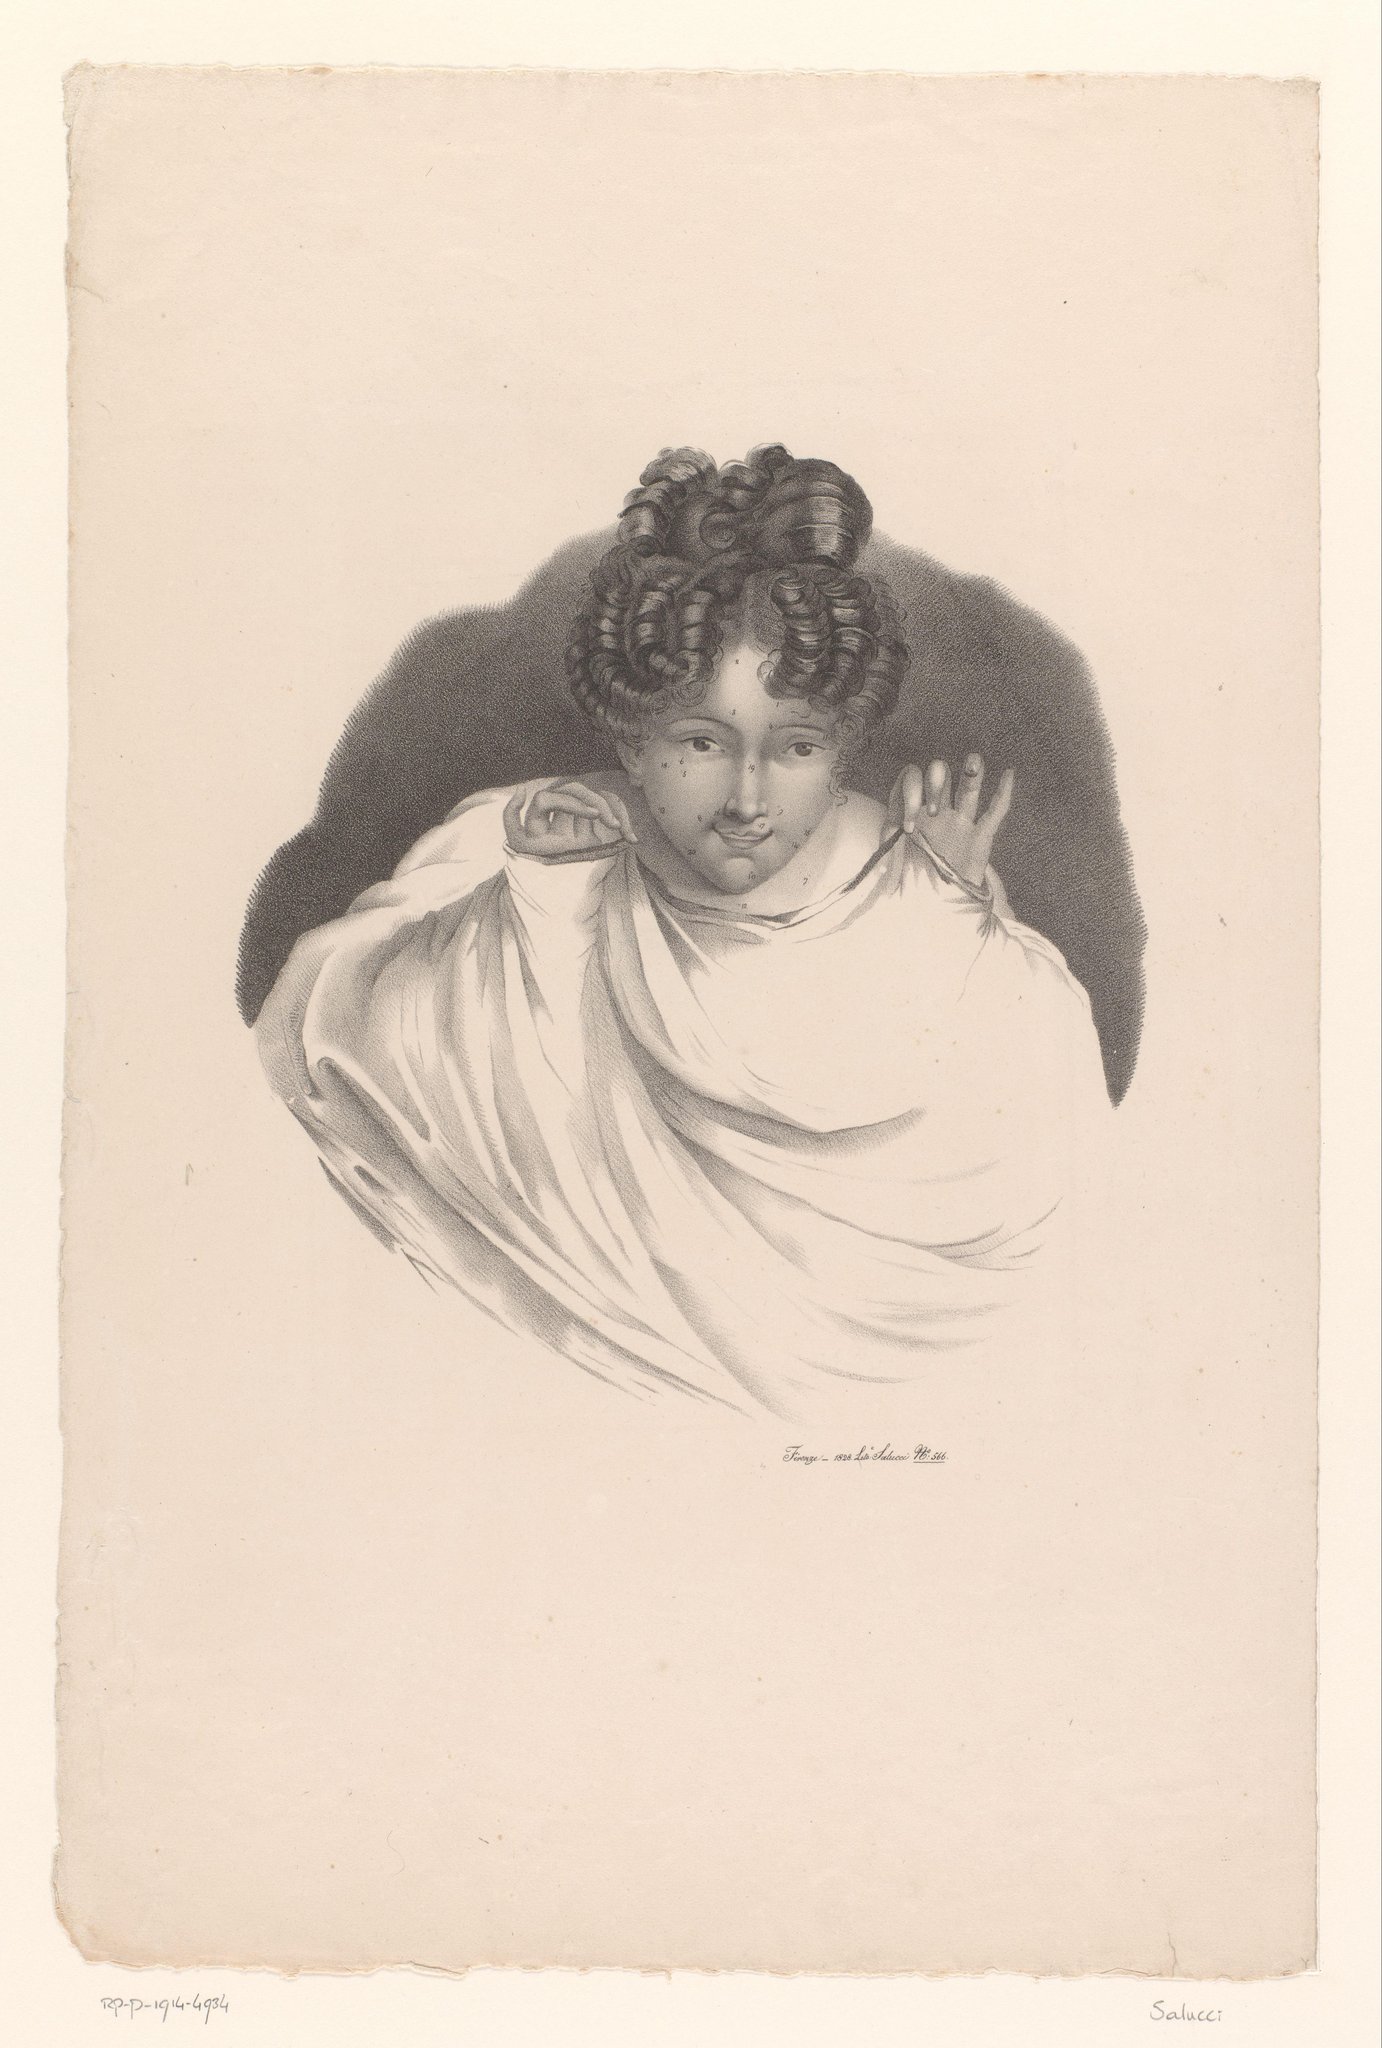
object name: print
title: Vrouw met kleed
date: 1828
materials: paper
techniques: lithograph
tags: anonymous historical person portrayed - bb - woman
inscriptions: collector's mark: Lugt 2228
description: Een vrouw met een kleed in haar handen. Op haar gezicht staan nummers van één tot en met twintig. Genummerd rechtsonder: No. 566.